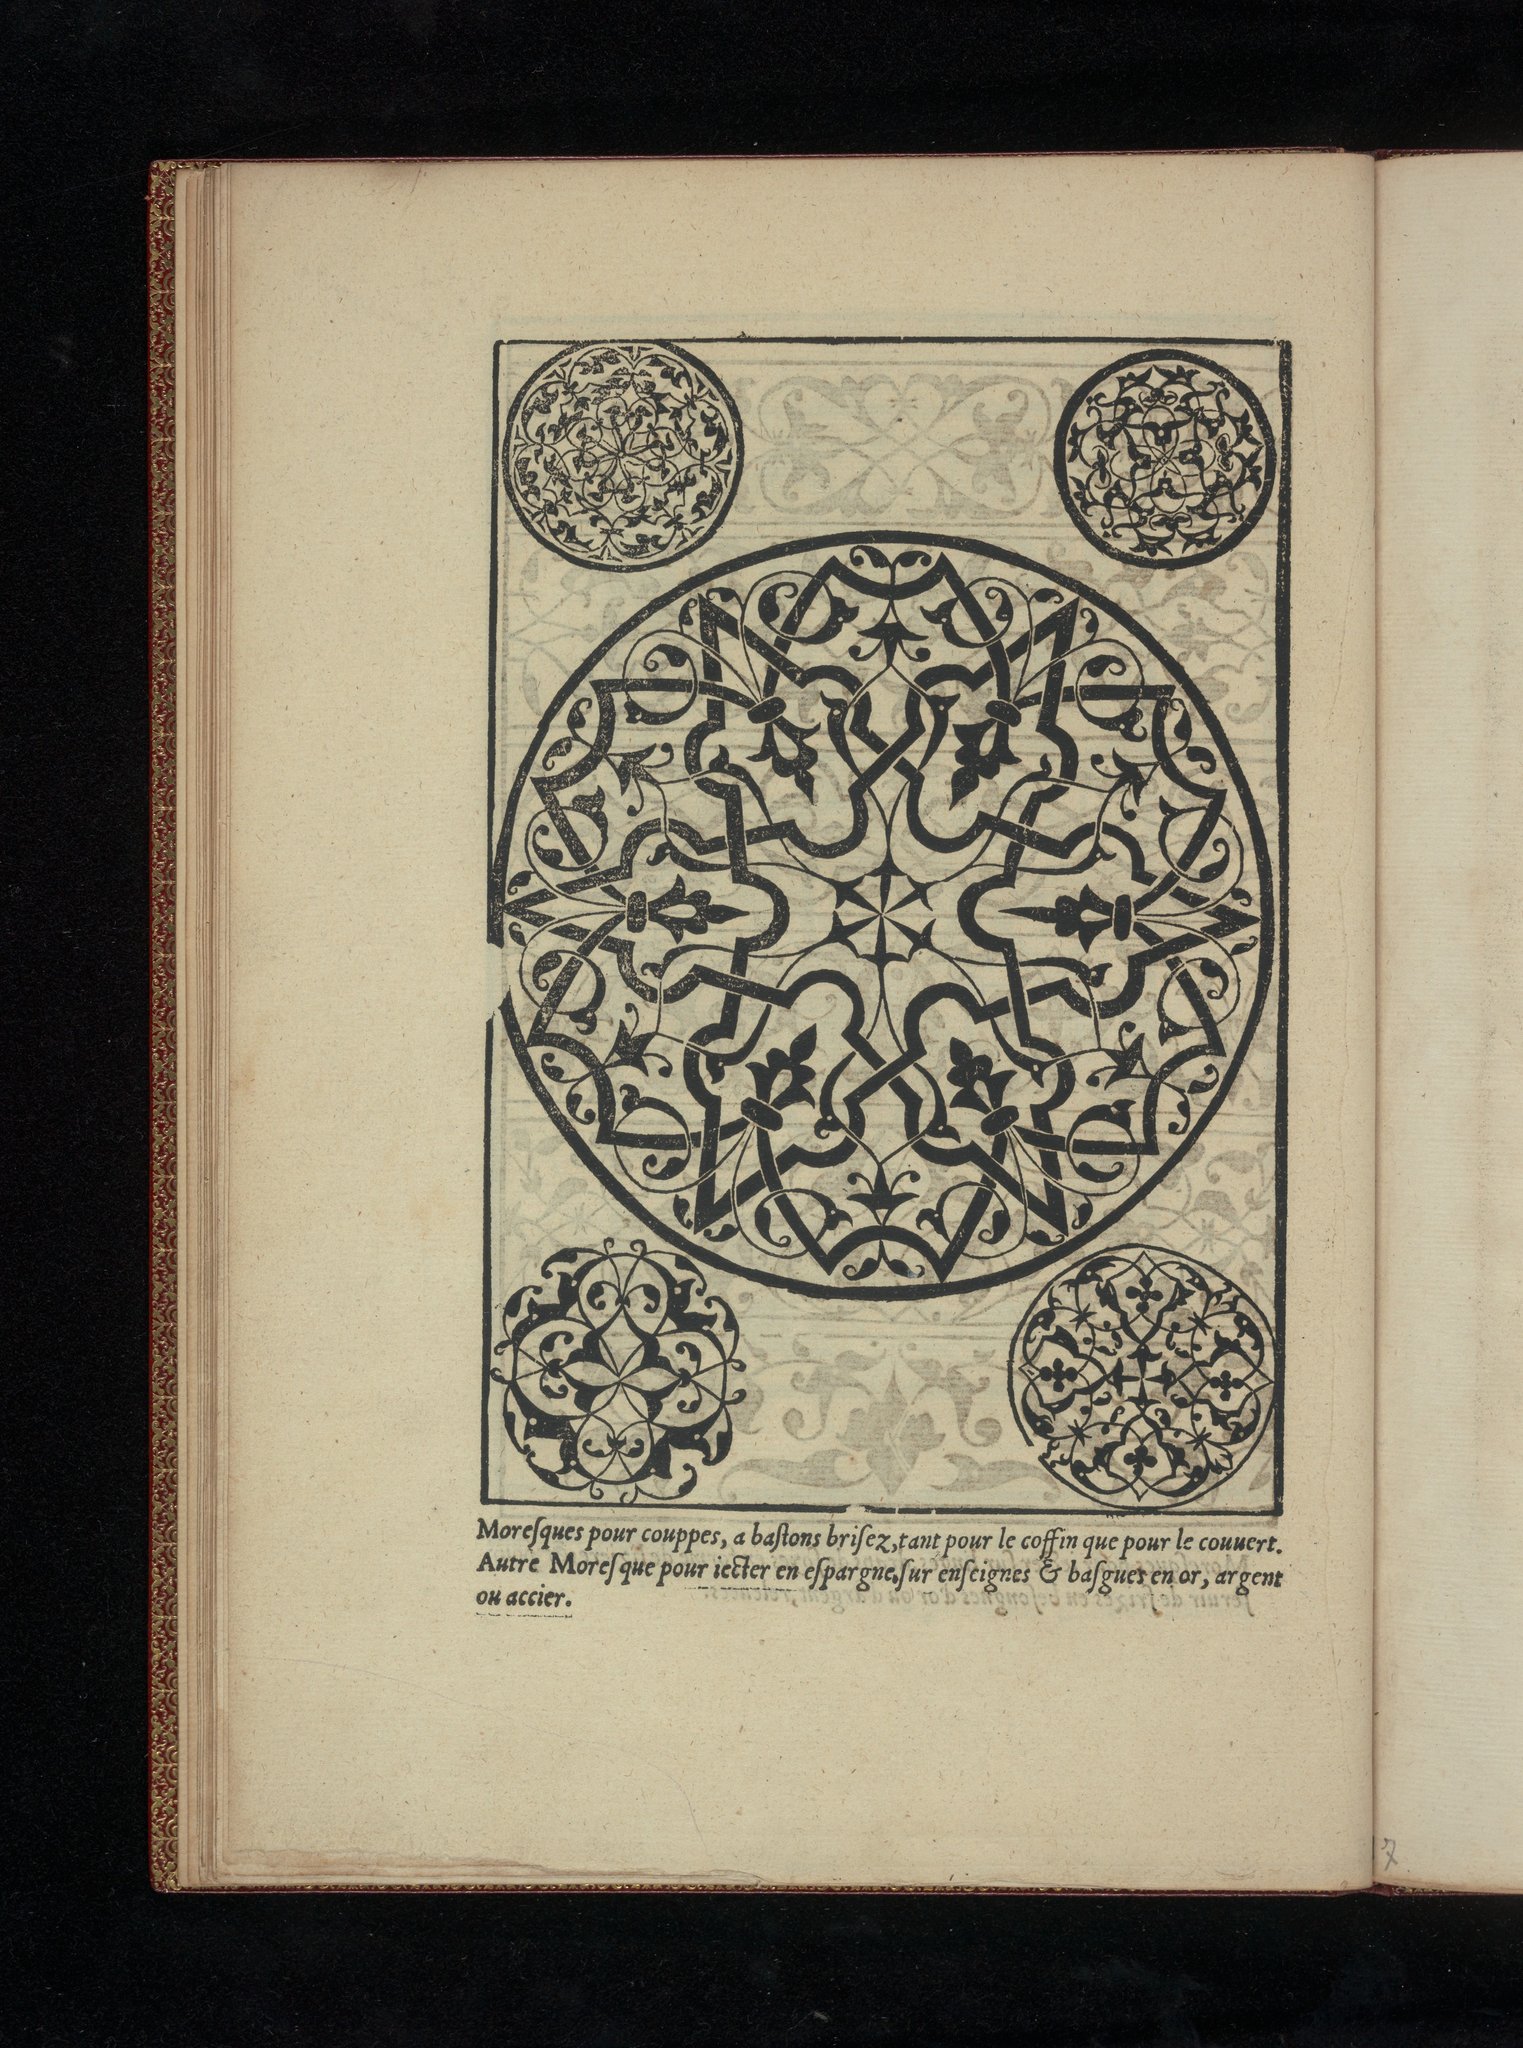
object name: book print ornament architecture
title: Livre de Moresques, page 17 (verso)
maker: francesco di pellegrino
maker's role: artist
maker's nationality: italian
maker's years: 1525-1552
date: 1546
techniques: woodcut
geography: france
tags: ornament